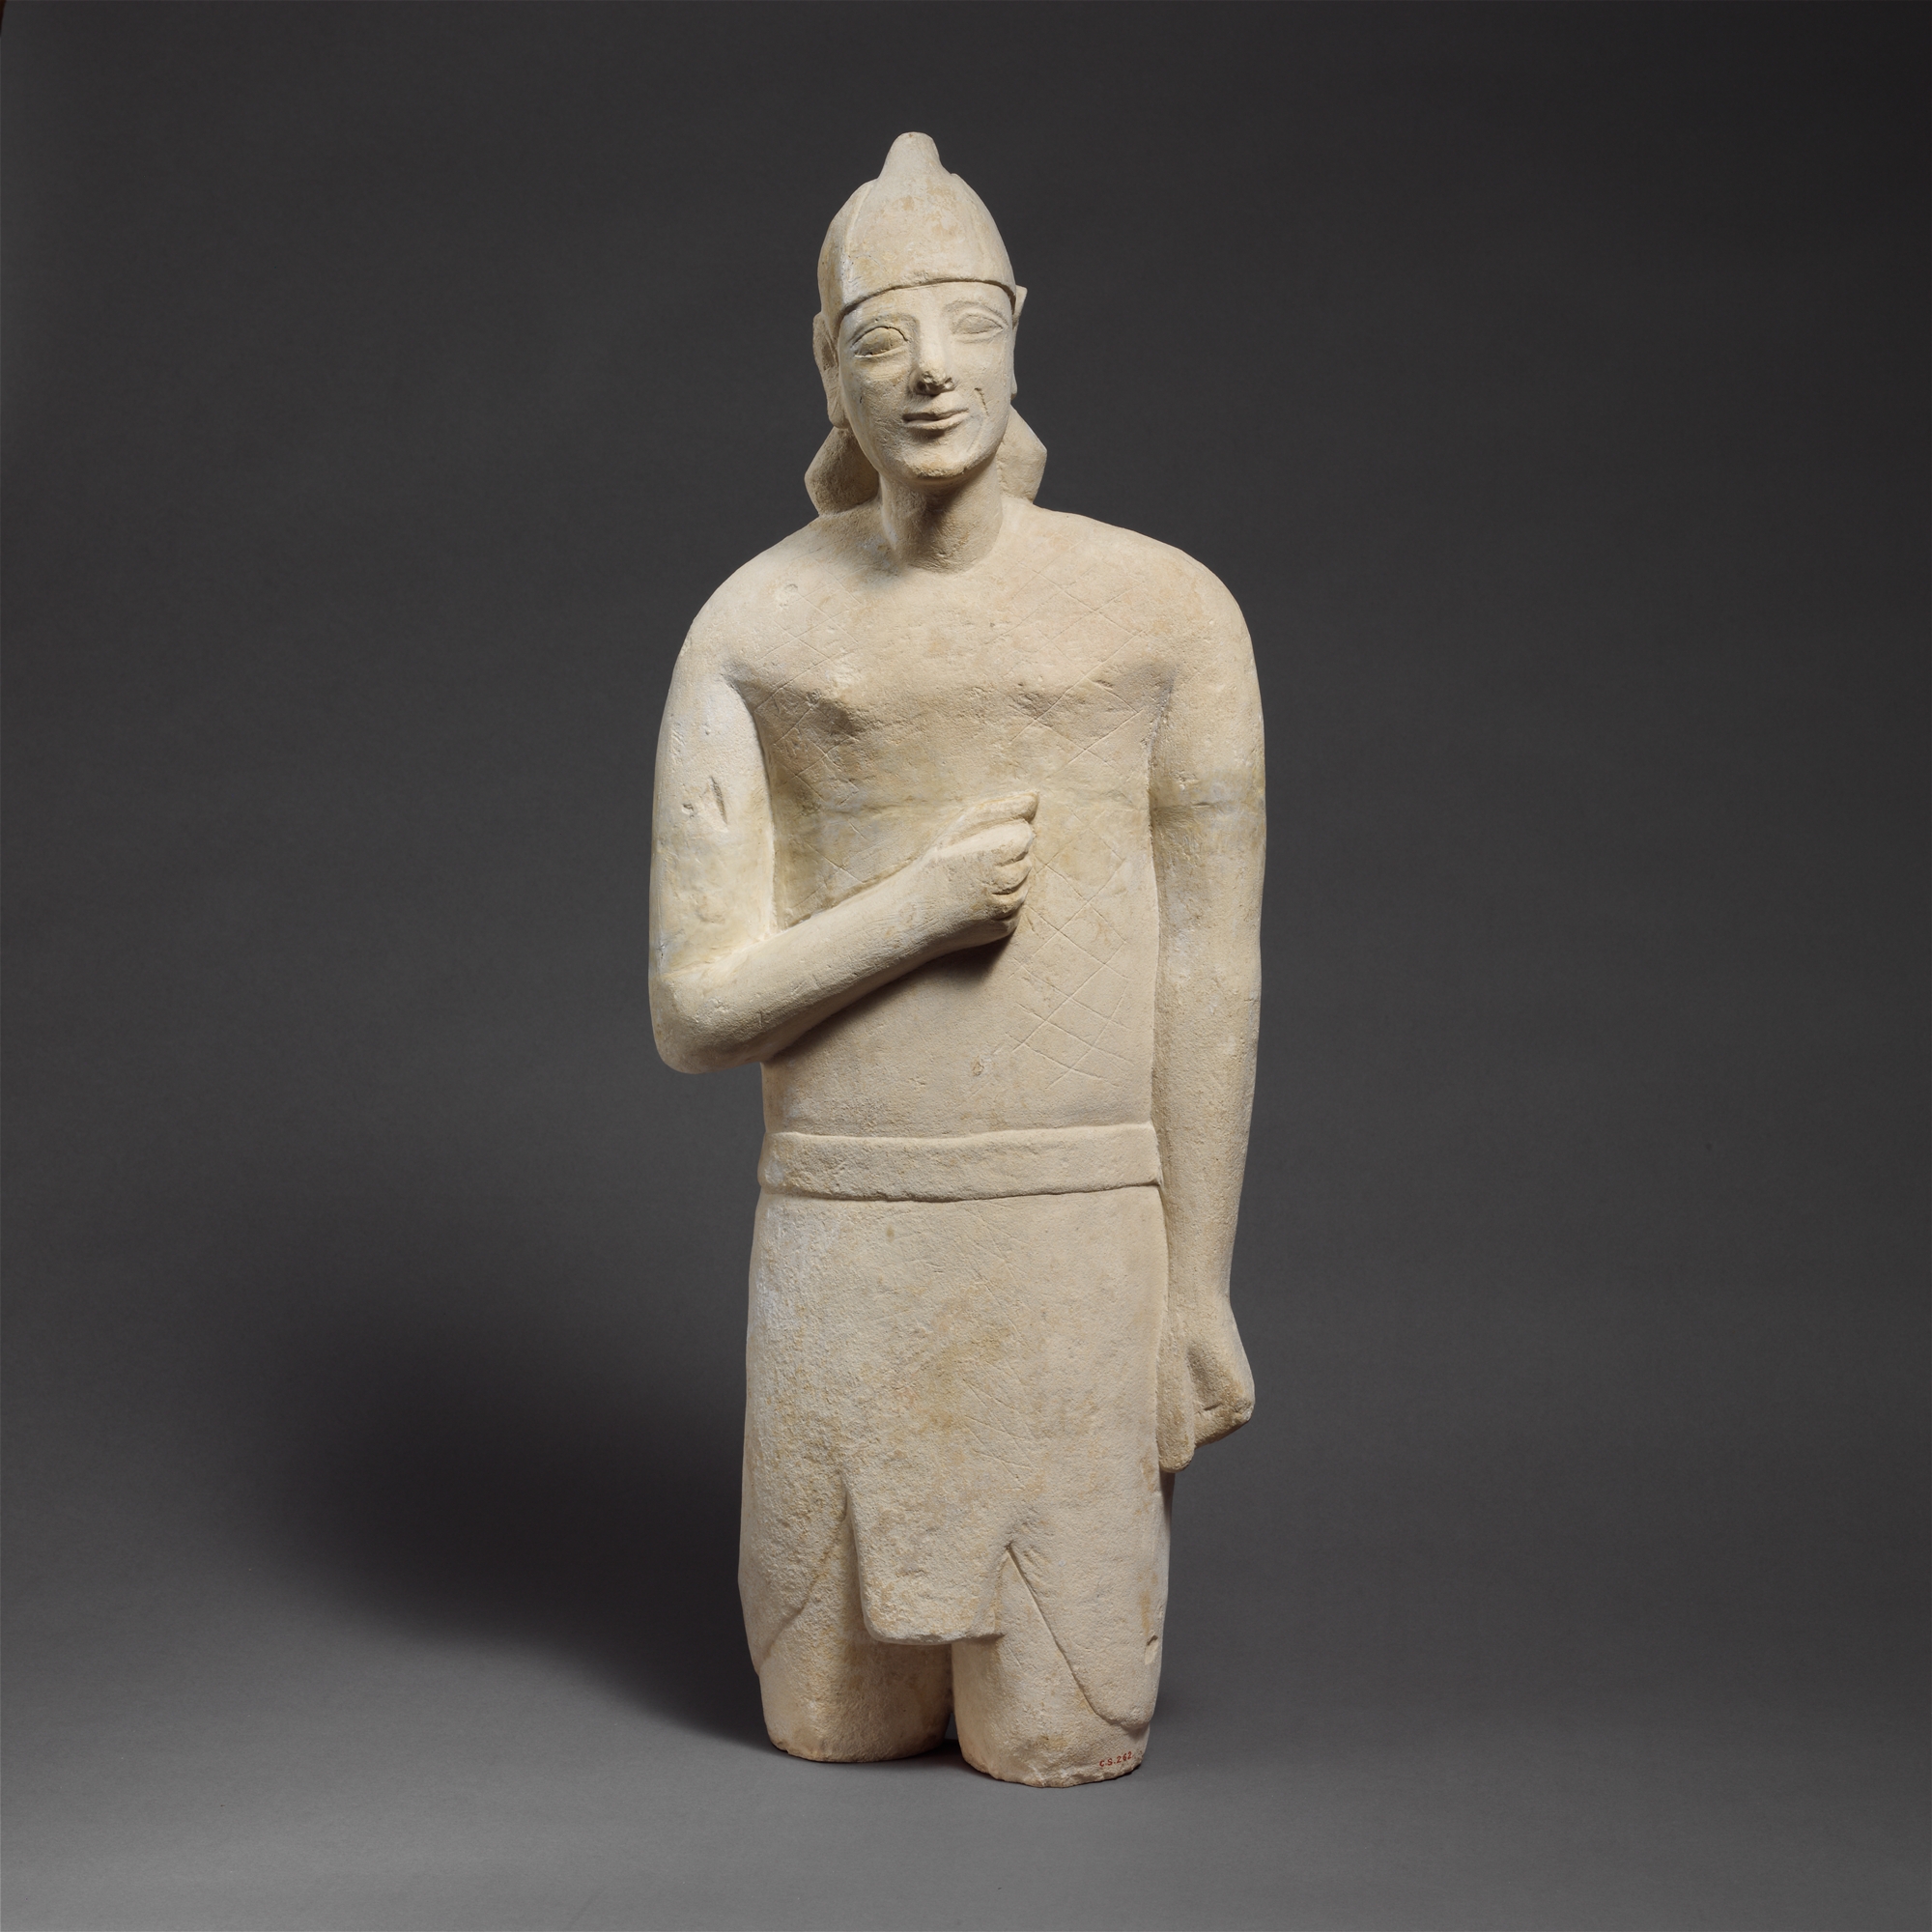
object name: statue of a votary, male, in mixed oriental garment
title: Limestone statuette of a beardless male votary in Egyptianizing dress wearing a helmet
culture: cypriot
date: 600-551 BCE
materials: limestone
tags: helmets,men